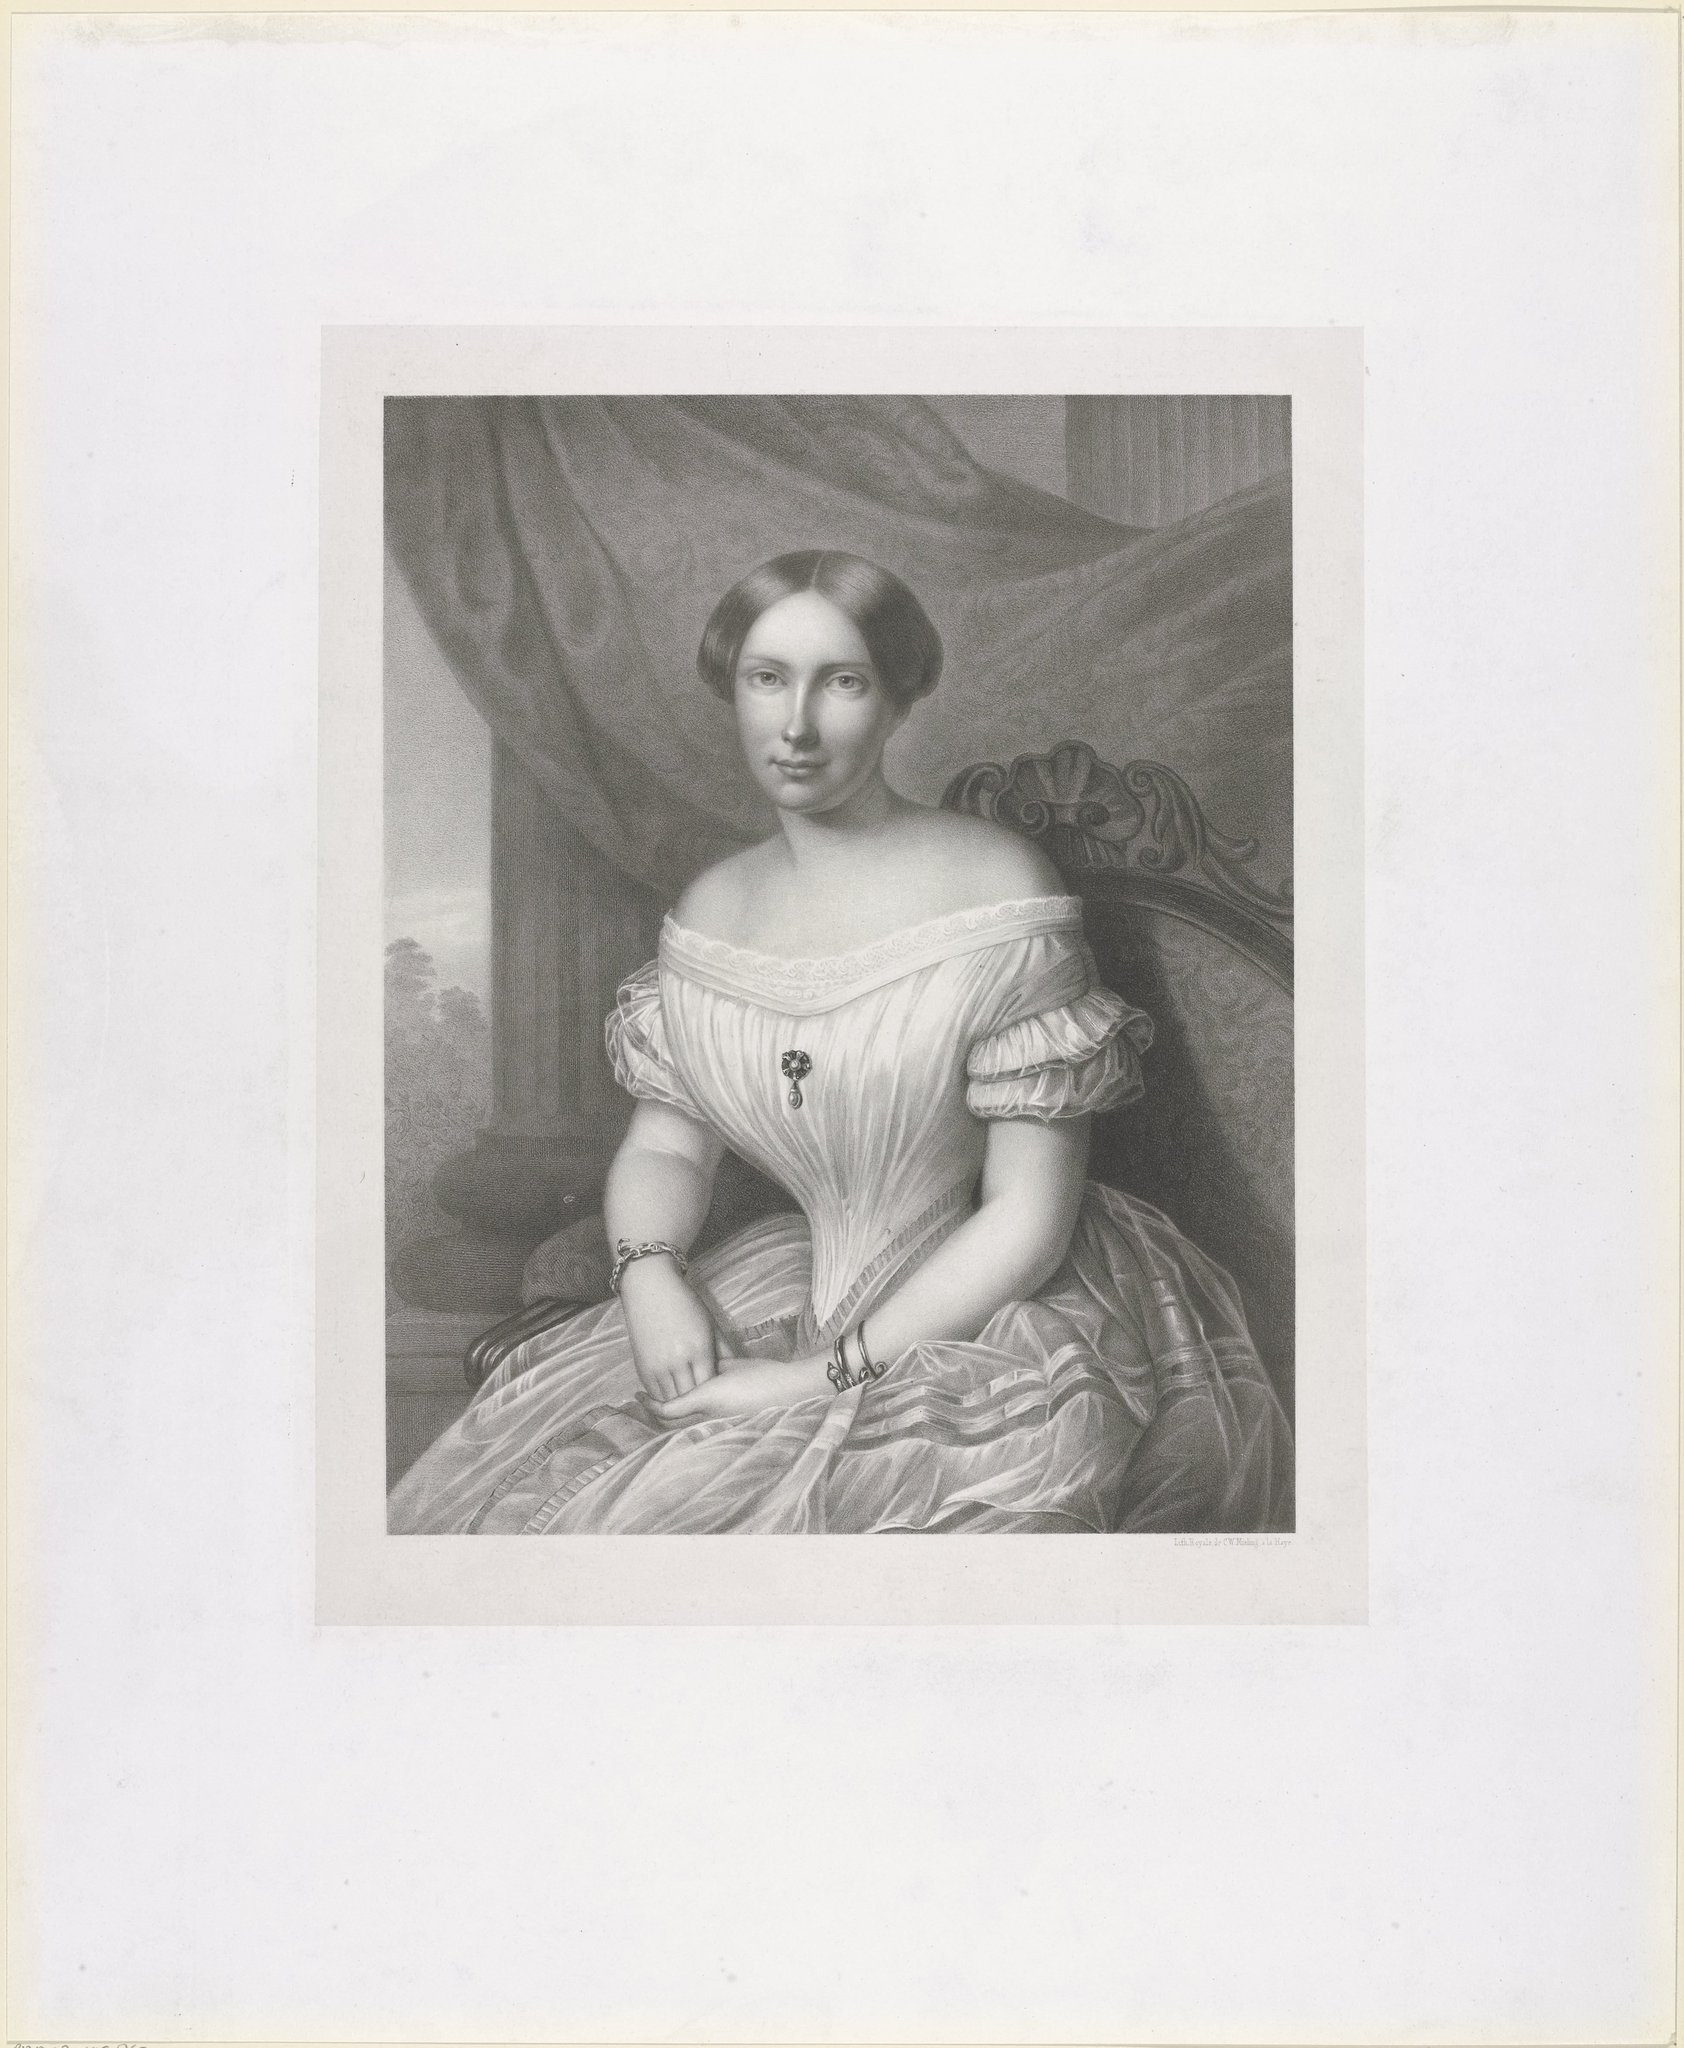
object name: print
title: Portret van Louise, prinses der Nederlanden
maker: Anonymous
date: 1850-1871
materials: paper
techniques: lithograph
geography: the hague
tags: the hague, historical persons - bb - woman, princess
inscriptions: collector's mark: Lugt 963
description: De hier vermelde titel verwijst naar de hoogst verkregen titel van de geportretteerde, niet per se naar de titel die de geportretteerde op deze voorstelling draagt.